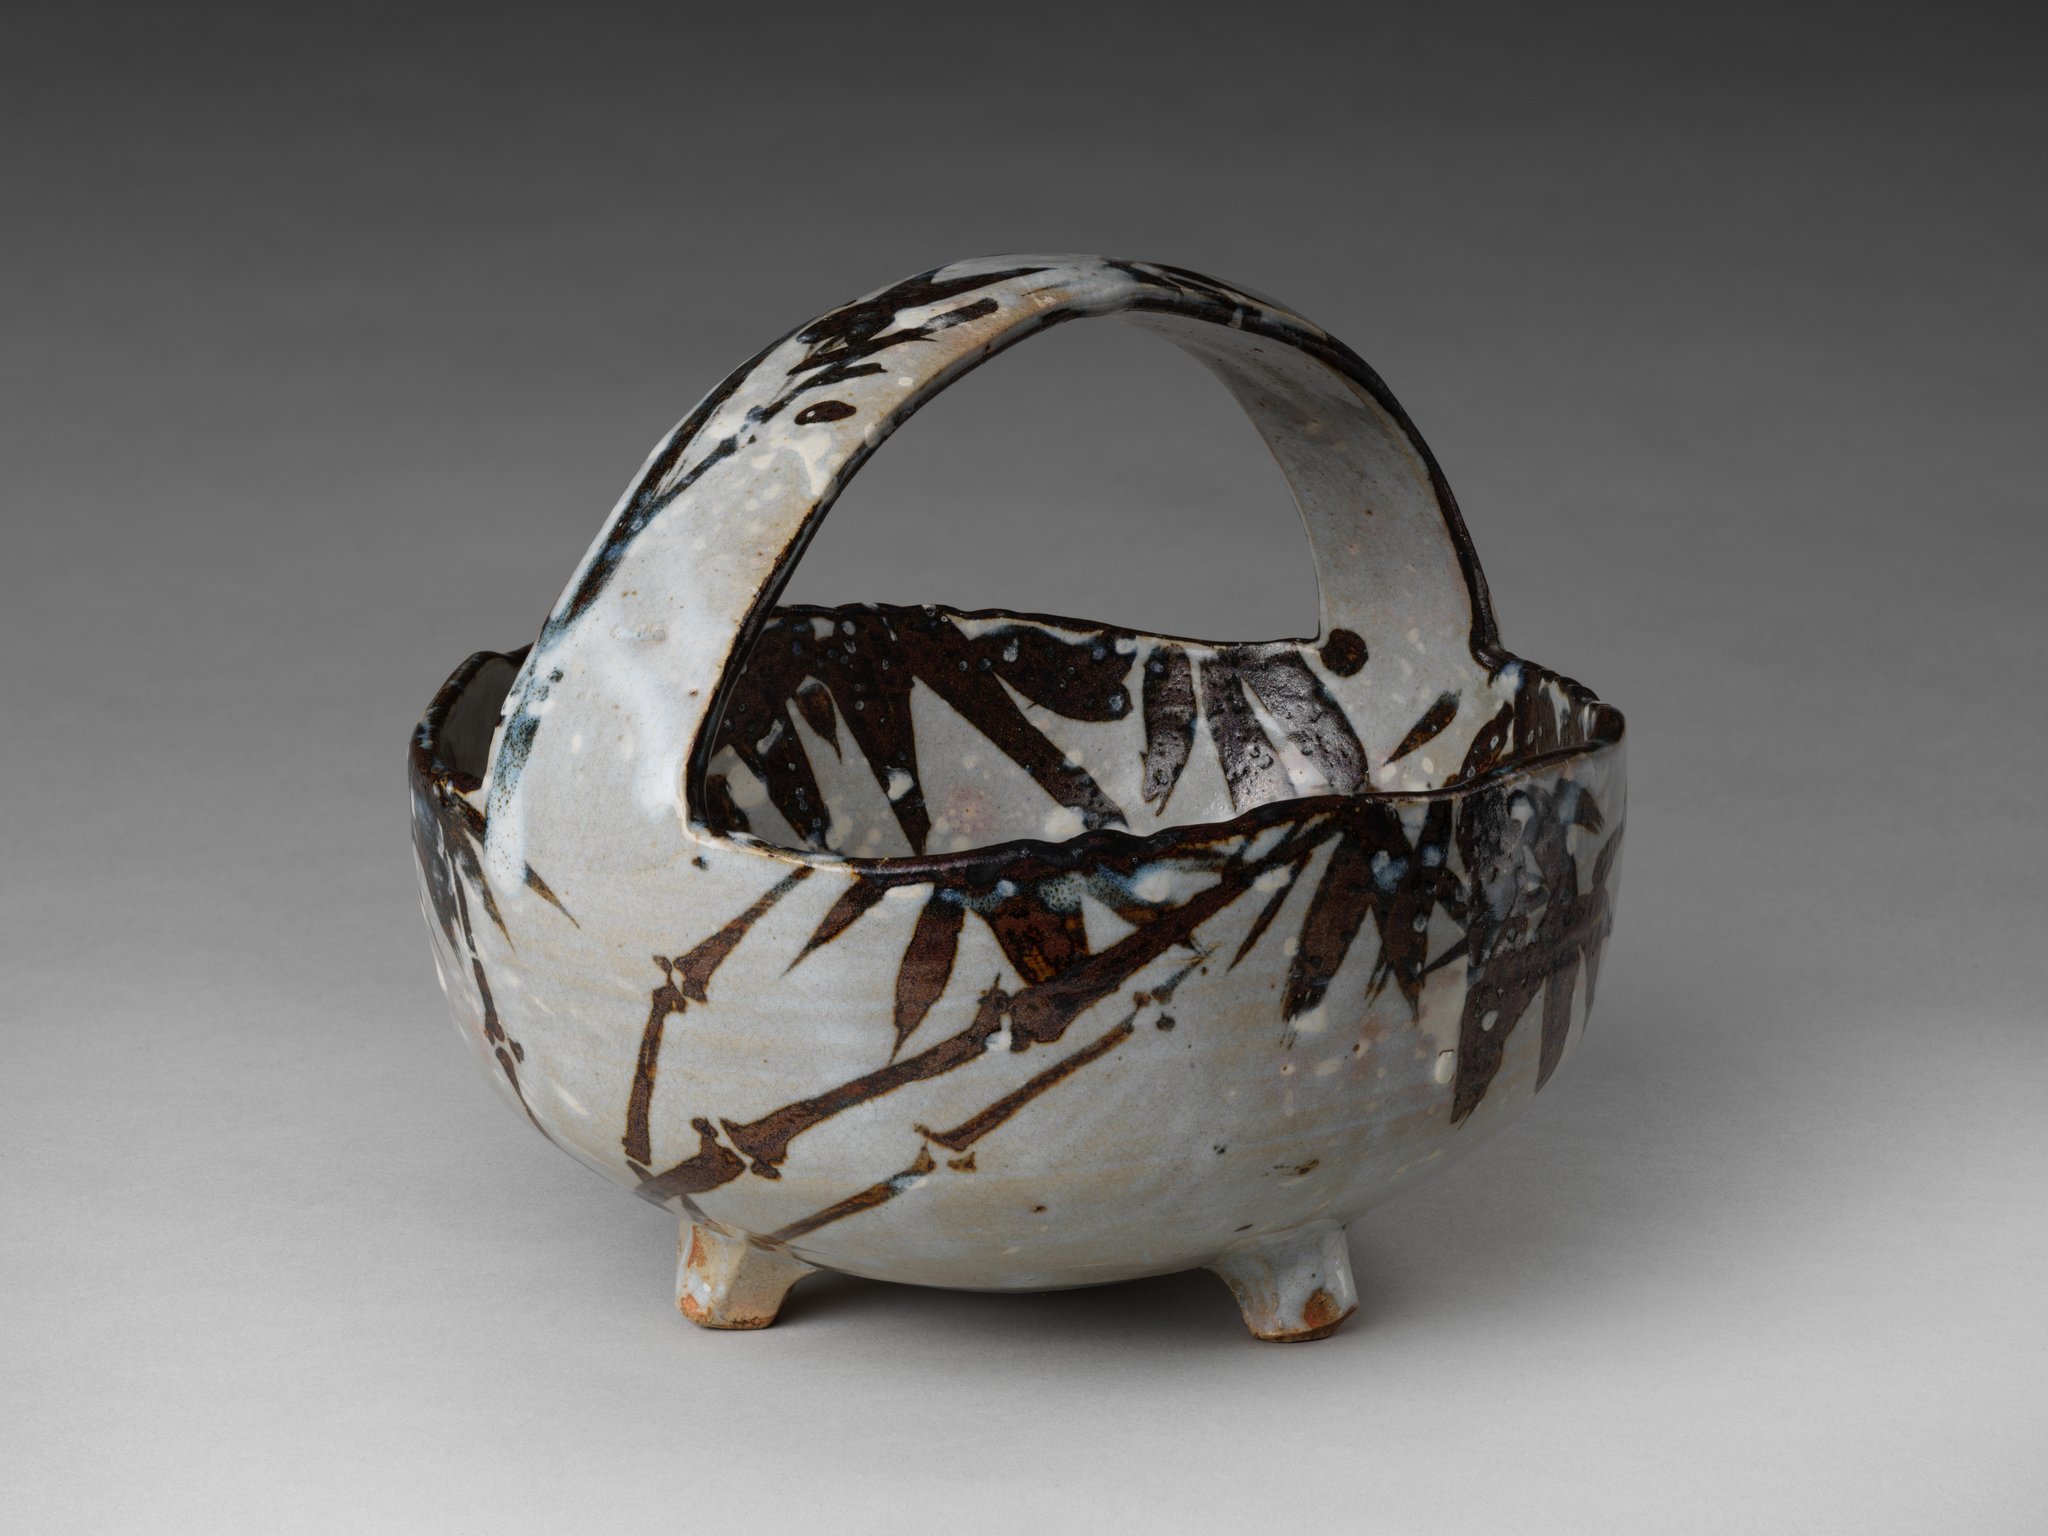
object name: bowl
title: Bowl with Handle (Tebachi) with Bamboo in Snow Pattern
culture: japanese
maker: nin'ami dōhachi (takahashi dōhachi ii)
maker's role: artist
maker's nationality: japanese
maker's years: 1783-1855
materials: iron, stoneware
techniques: overglaze, underglaze